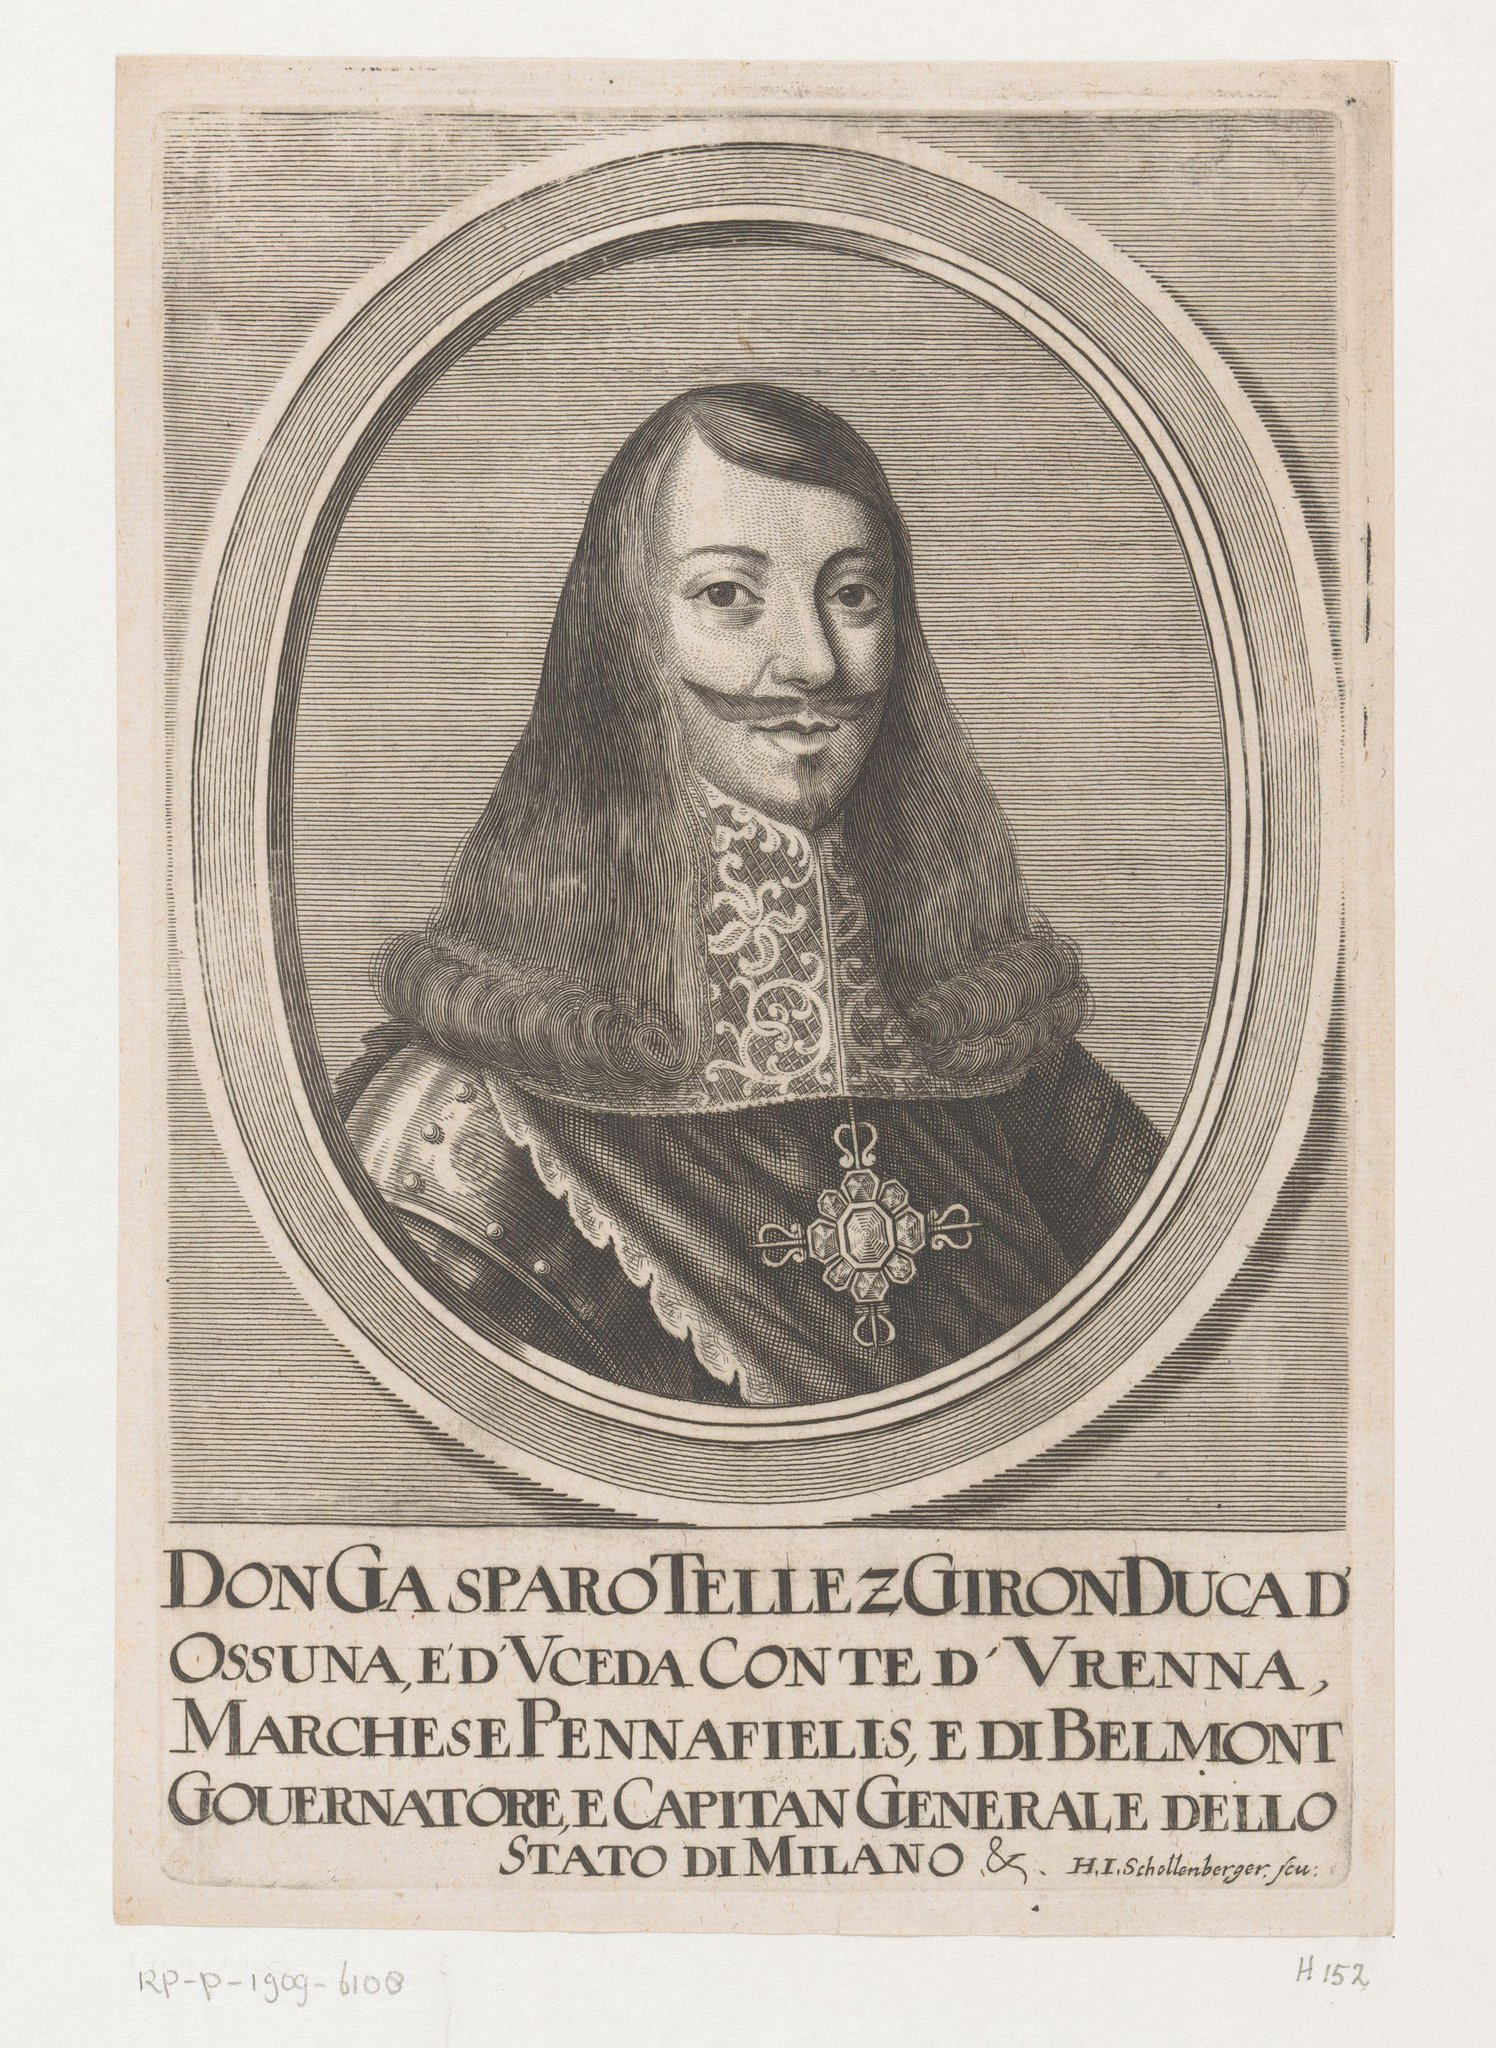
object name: print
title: Portret van Gaspar Téllez-Girón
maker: johann jacob schollenberger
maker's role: print maker, publisher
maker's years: 1646-1689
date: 1670-1674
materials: paper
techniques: engraving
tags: politician, historical persons, politician, e.g. party leader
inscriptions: collector's mark: Lugt 2228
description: Deze prent is ook gebruikt in: Priorato, Galeazzo Gualdo. Historia di Leopoldo Cesare, Continente le cose piu memorabili successe in Europa dal 1656 fino al 1670. Descritta dal Co. Galeazzo Gvaldo Priorato. Wenen: G. B. Hacque, 1670-1674.